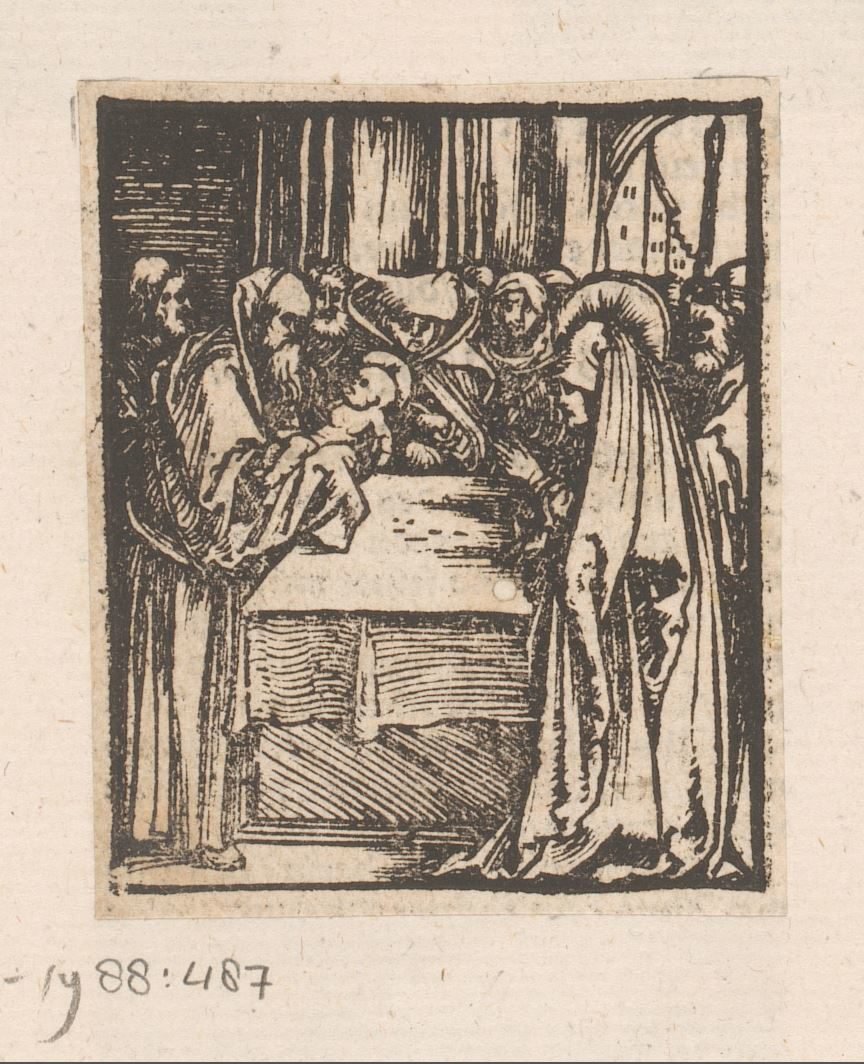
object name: book illustration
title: Presentatie van Christus in de tempel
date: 1536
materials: paper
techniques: woodcut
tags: presentation of the christ-child in the temple, usually simeon (and anna) present (luke 2:22-39)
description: Prent afkomstig uit: Evangelia und Epistel. Neurenberg: Hans Guldenmund, 1536.